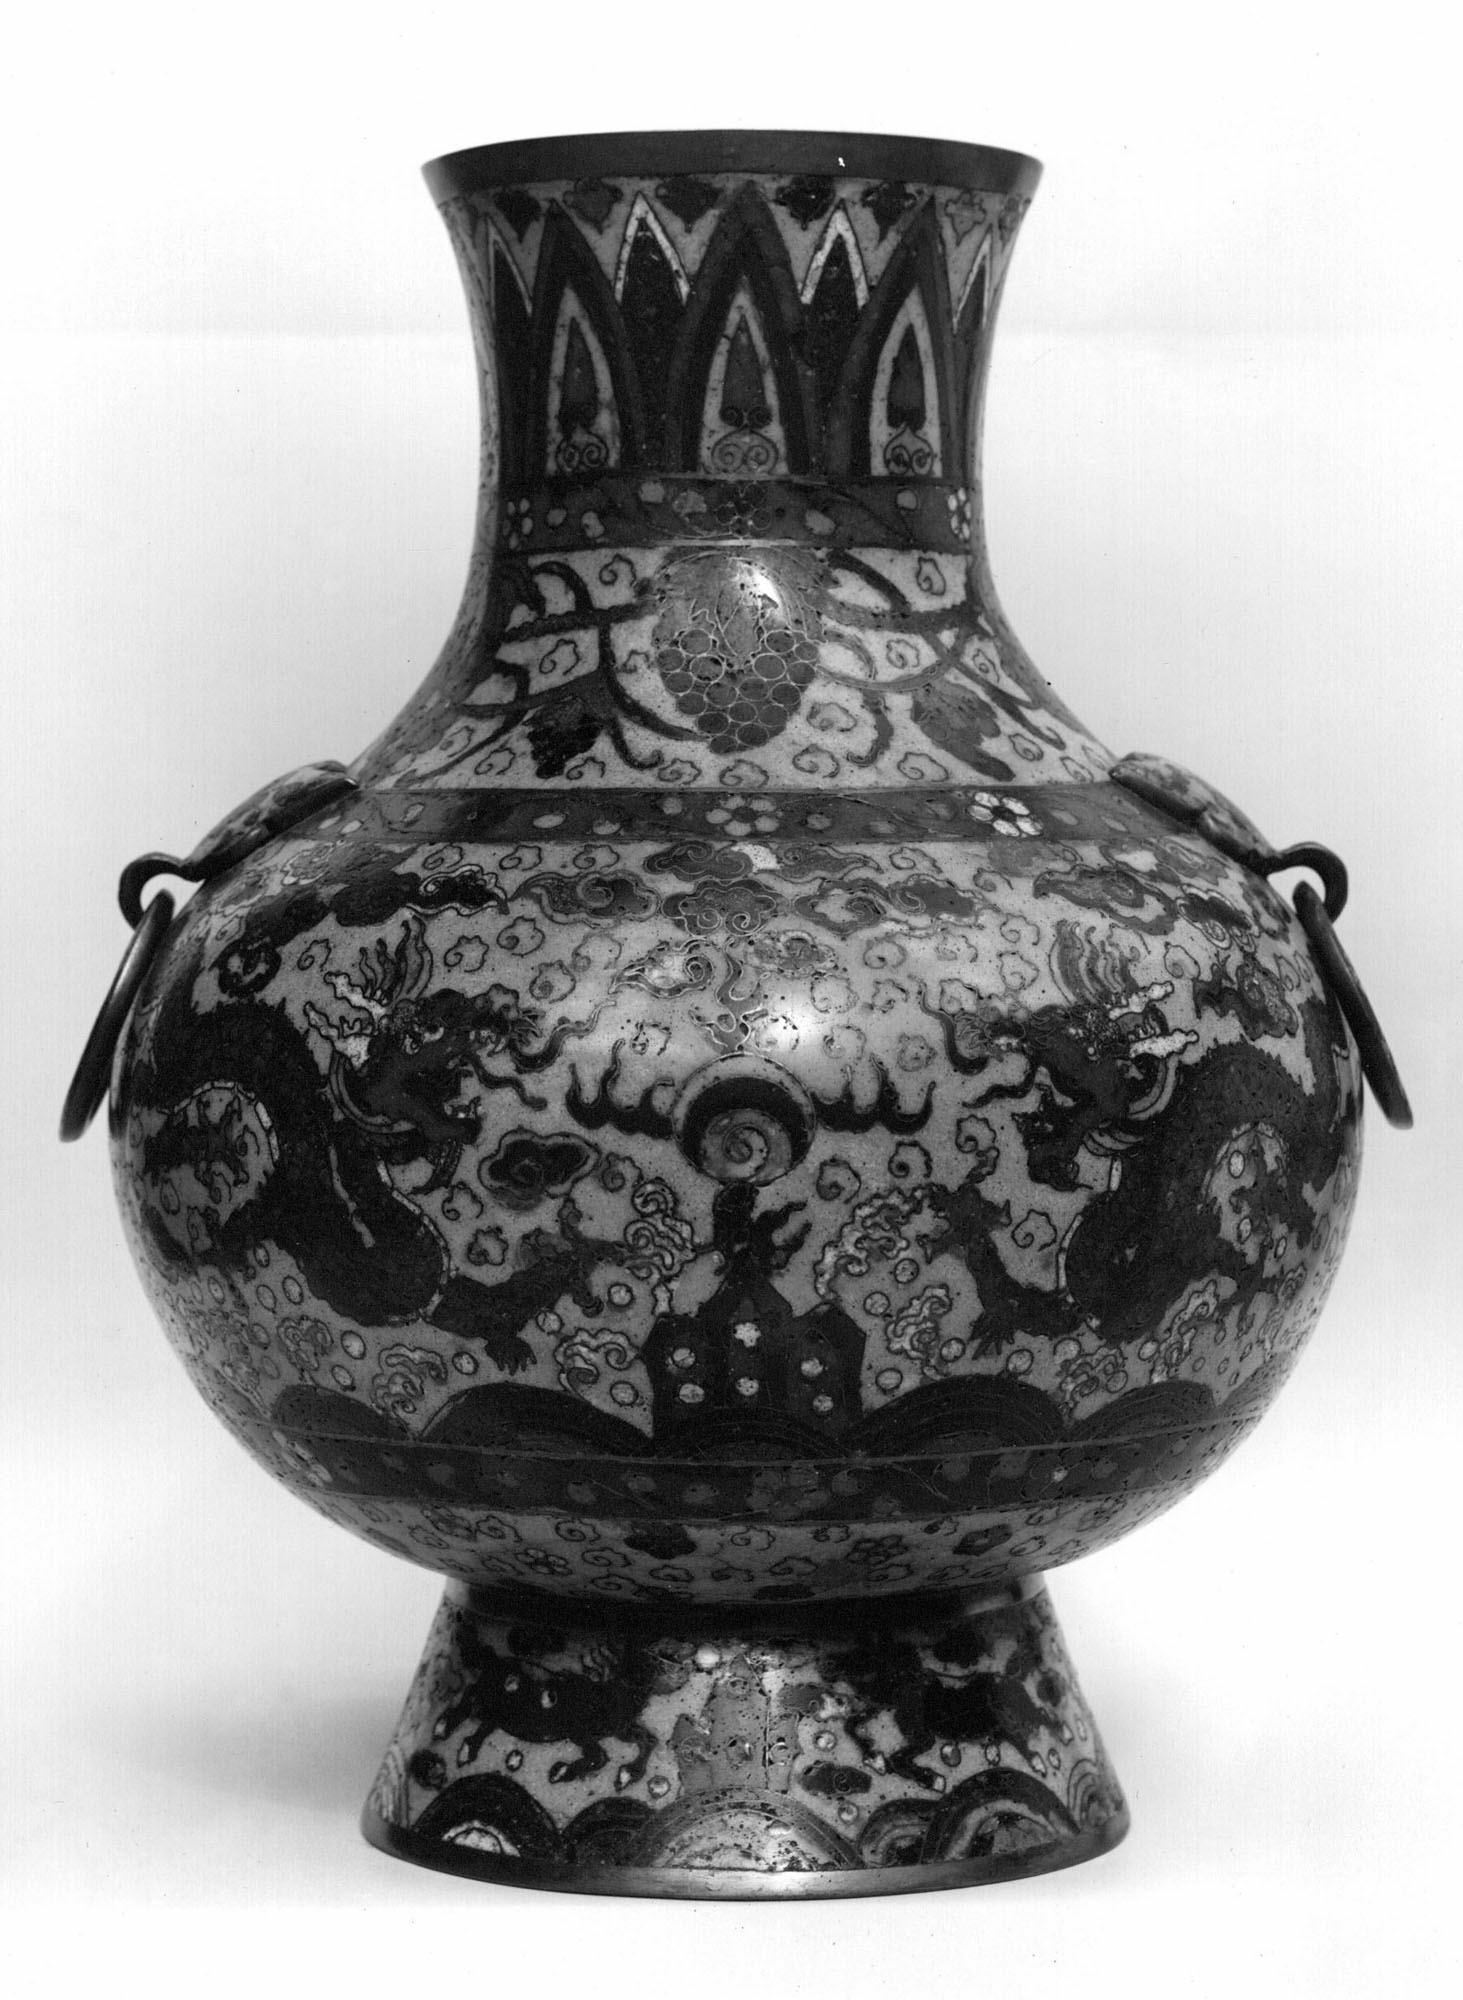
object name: vase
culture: chinese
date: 1368-1644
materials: copper, enamel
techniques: enamel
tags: dragons